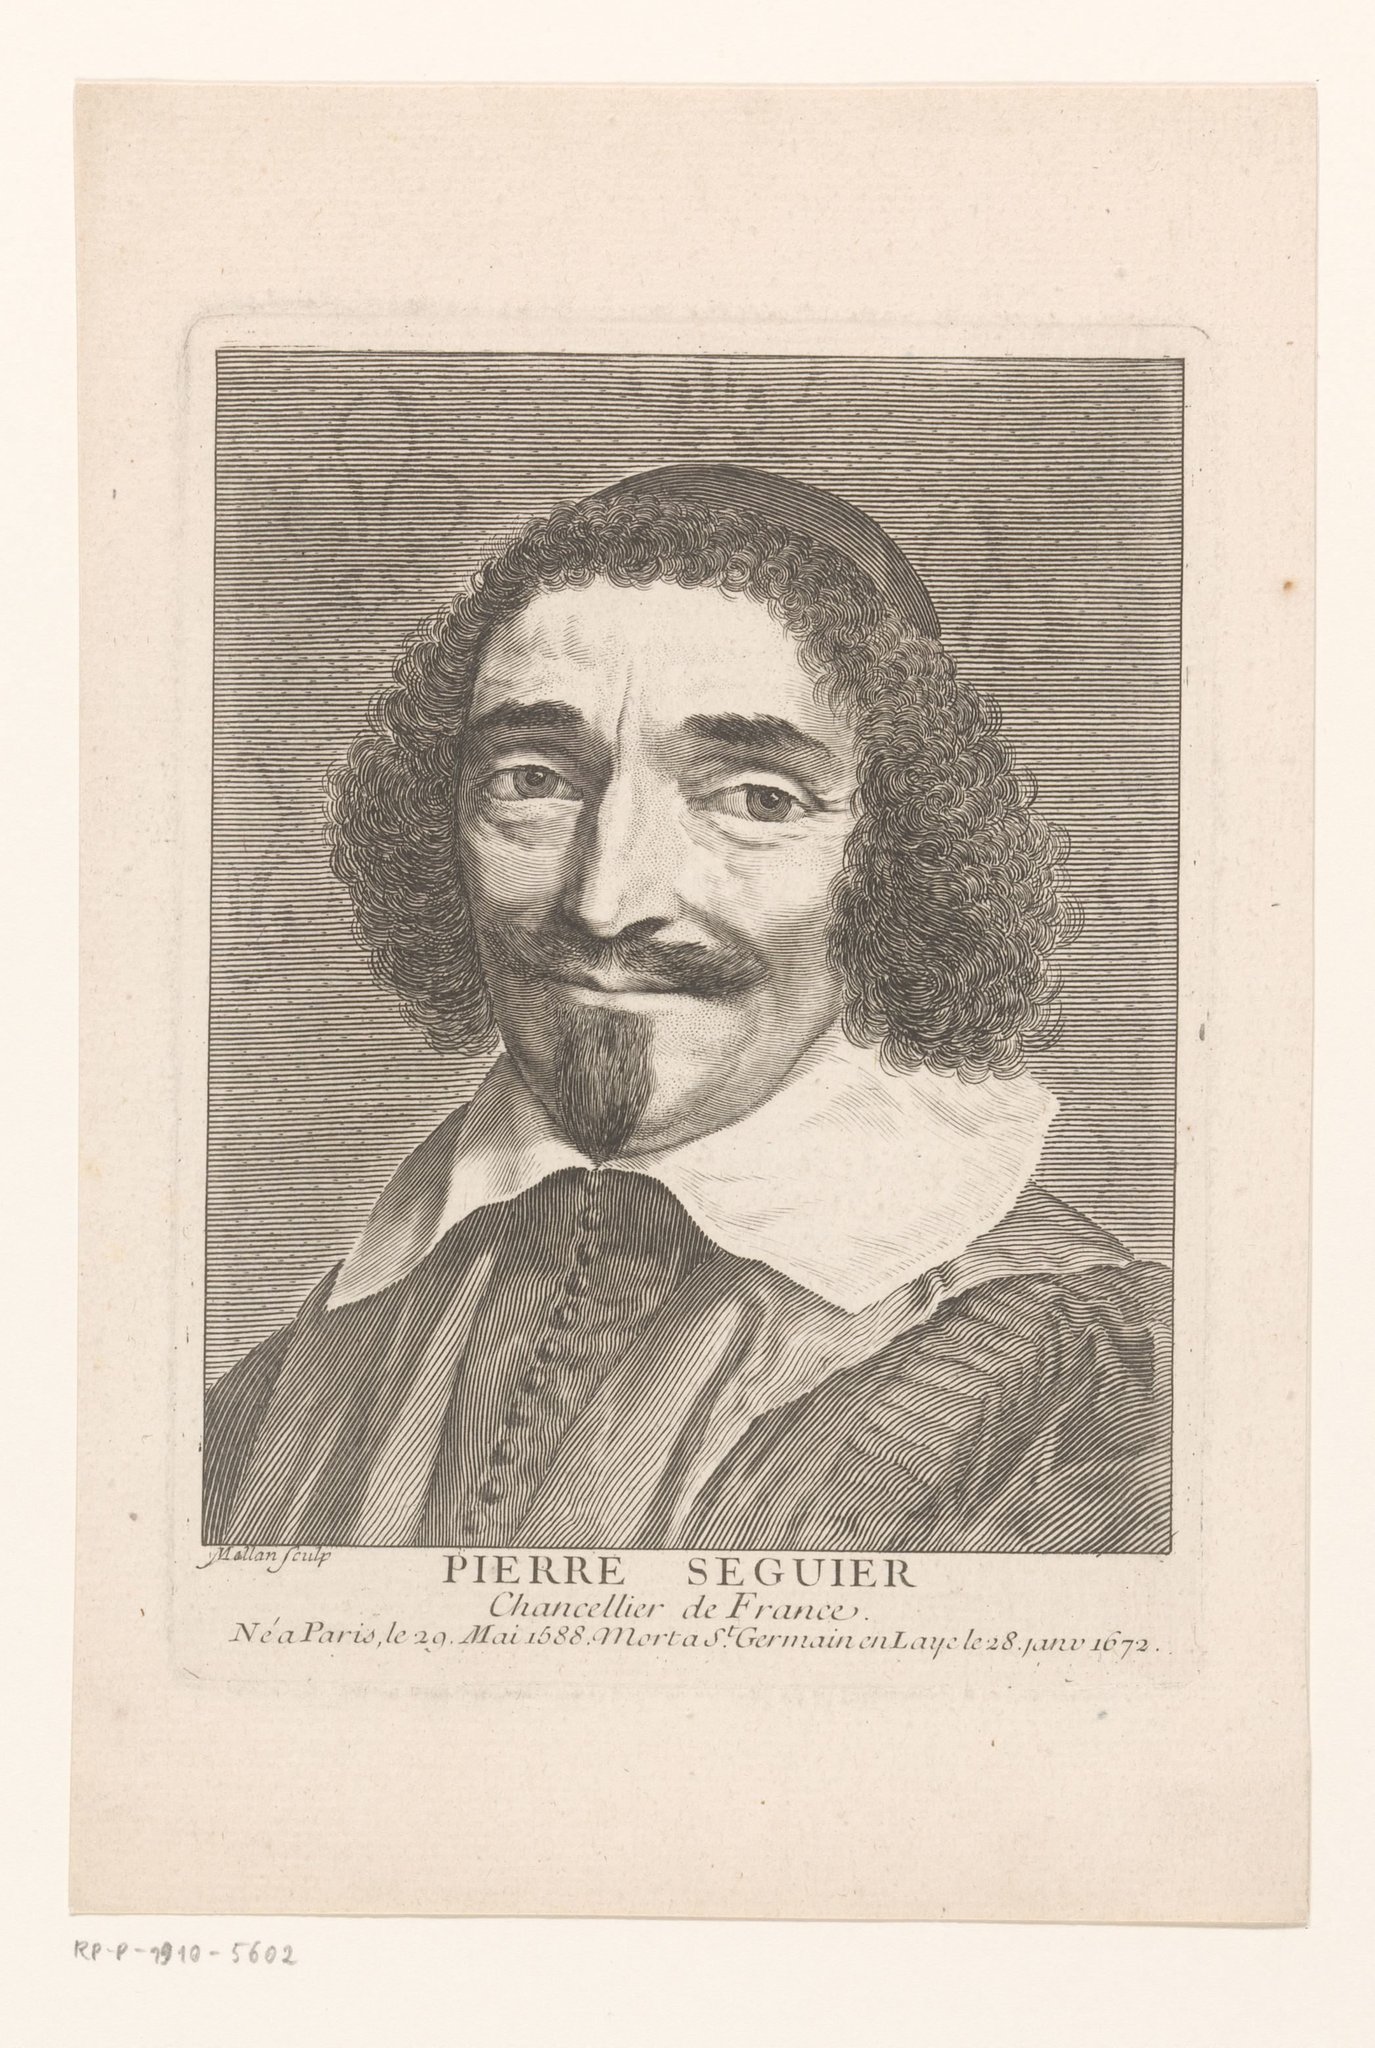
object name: print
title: Portret van Pierre Séguier op 51-jarige leeftijd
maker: claude mellan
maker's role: draughtsman, print maker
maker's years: 1598-1688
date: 1639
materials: paper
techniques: engraving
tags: paris, pierre séguier, historical persons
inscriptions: collector's mark: Lugt 2228